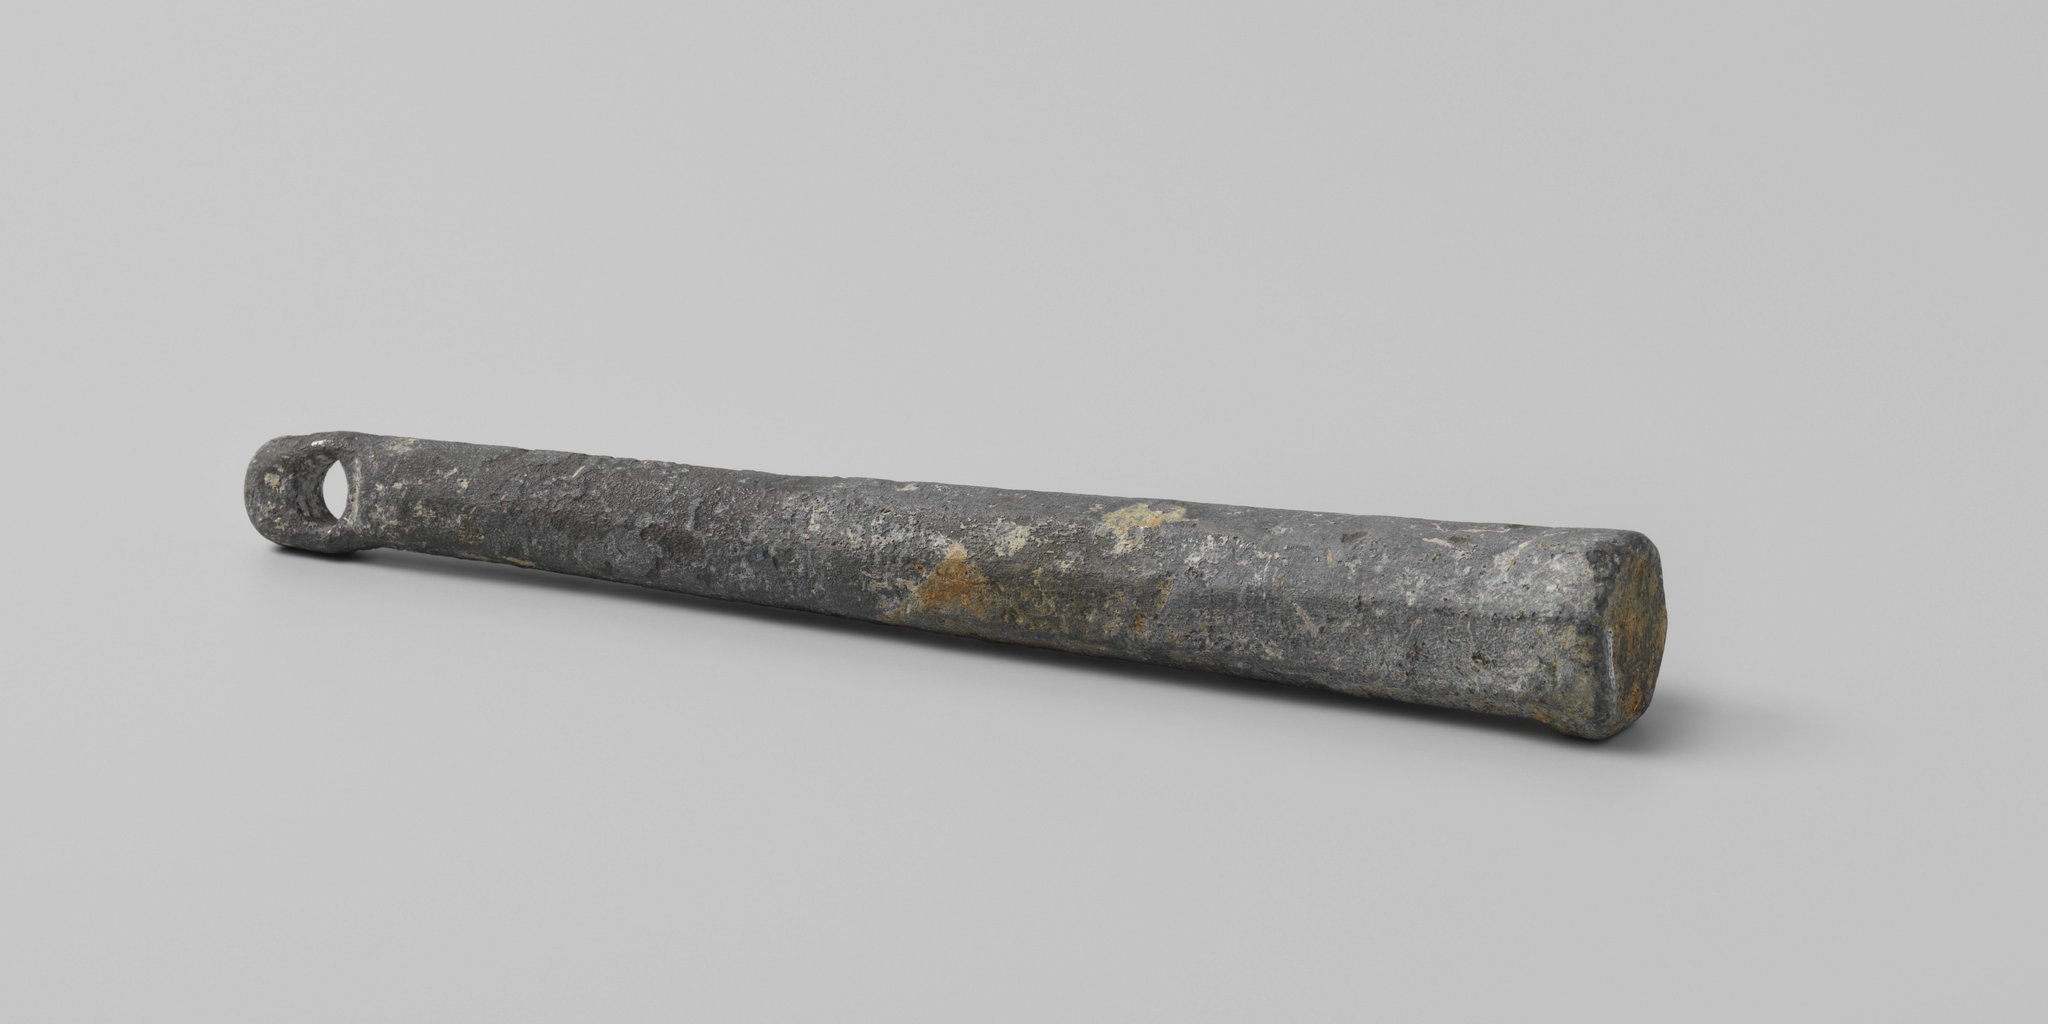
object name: sounding lead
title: Dieplood uit het wrak van de Oost-Indiëvaarder Hollandia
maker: Anonymous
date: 1700-1743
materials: lead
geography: netherlands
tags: verenigde oostindische compagnie, hollandia (schip), annet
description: Tools and instruments, navigation, sounding lead; octagonal faceted, tapering upwards, flat base, thickened on 2 sides, semicircular pierced upper end.